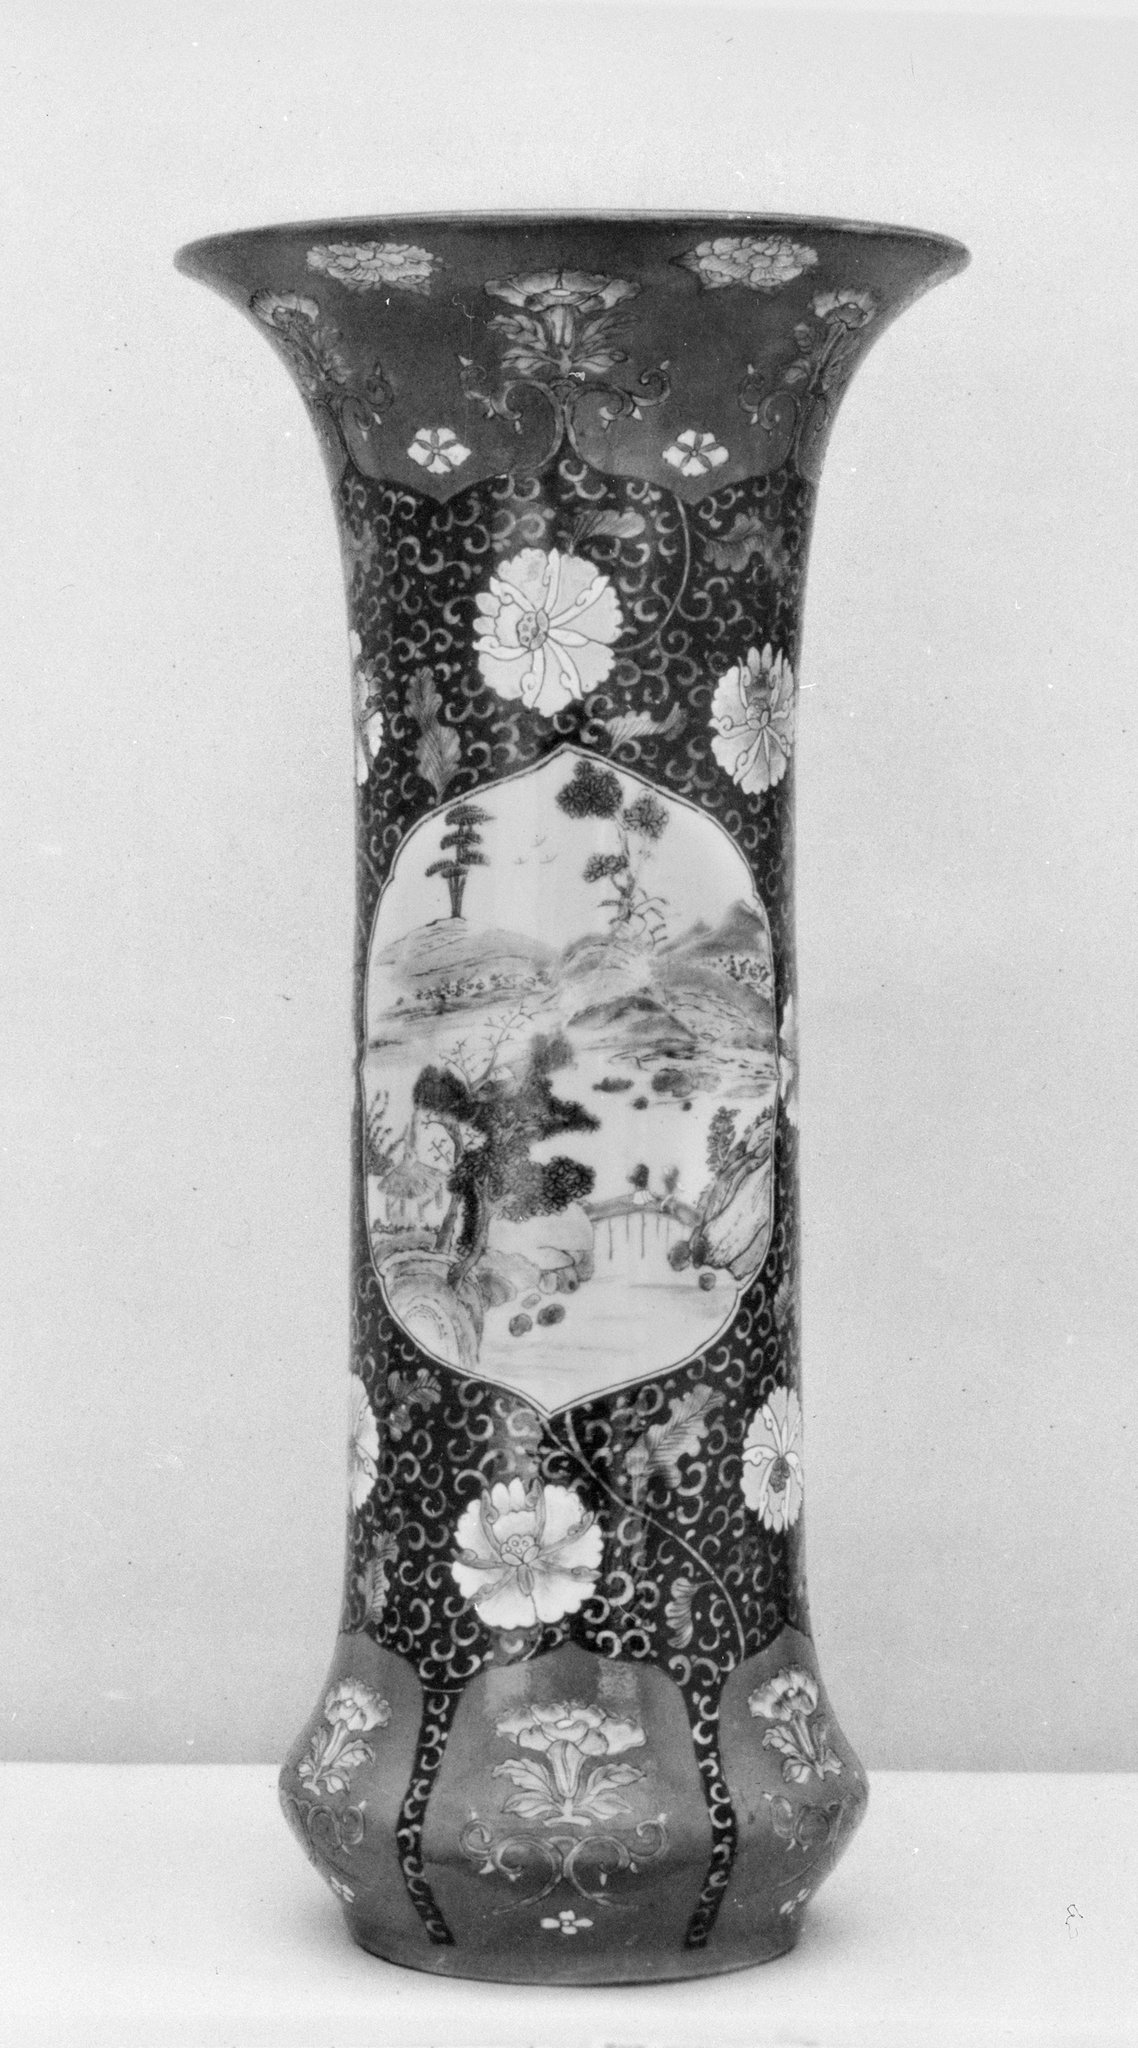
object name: vase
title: Vase with landscape and flowers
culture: chinese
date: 1701-1800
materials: enamel, porcelain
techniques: overglaze, painting, polychrome